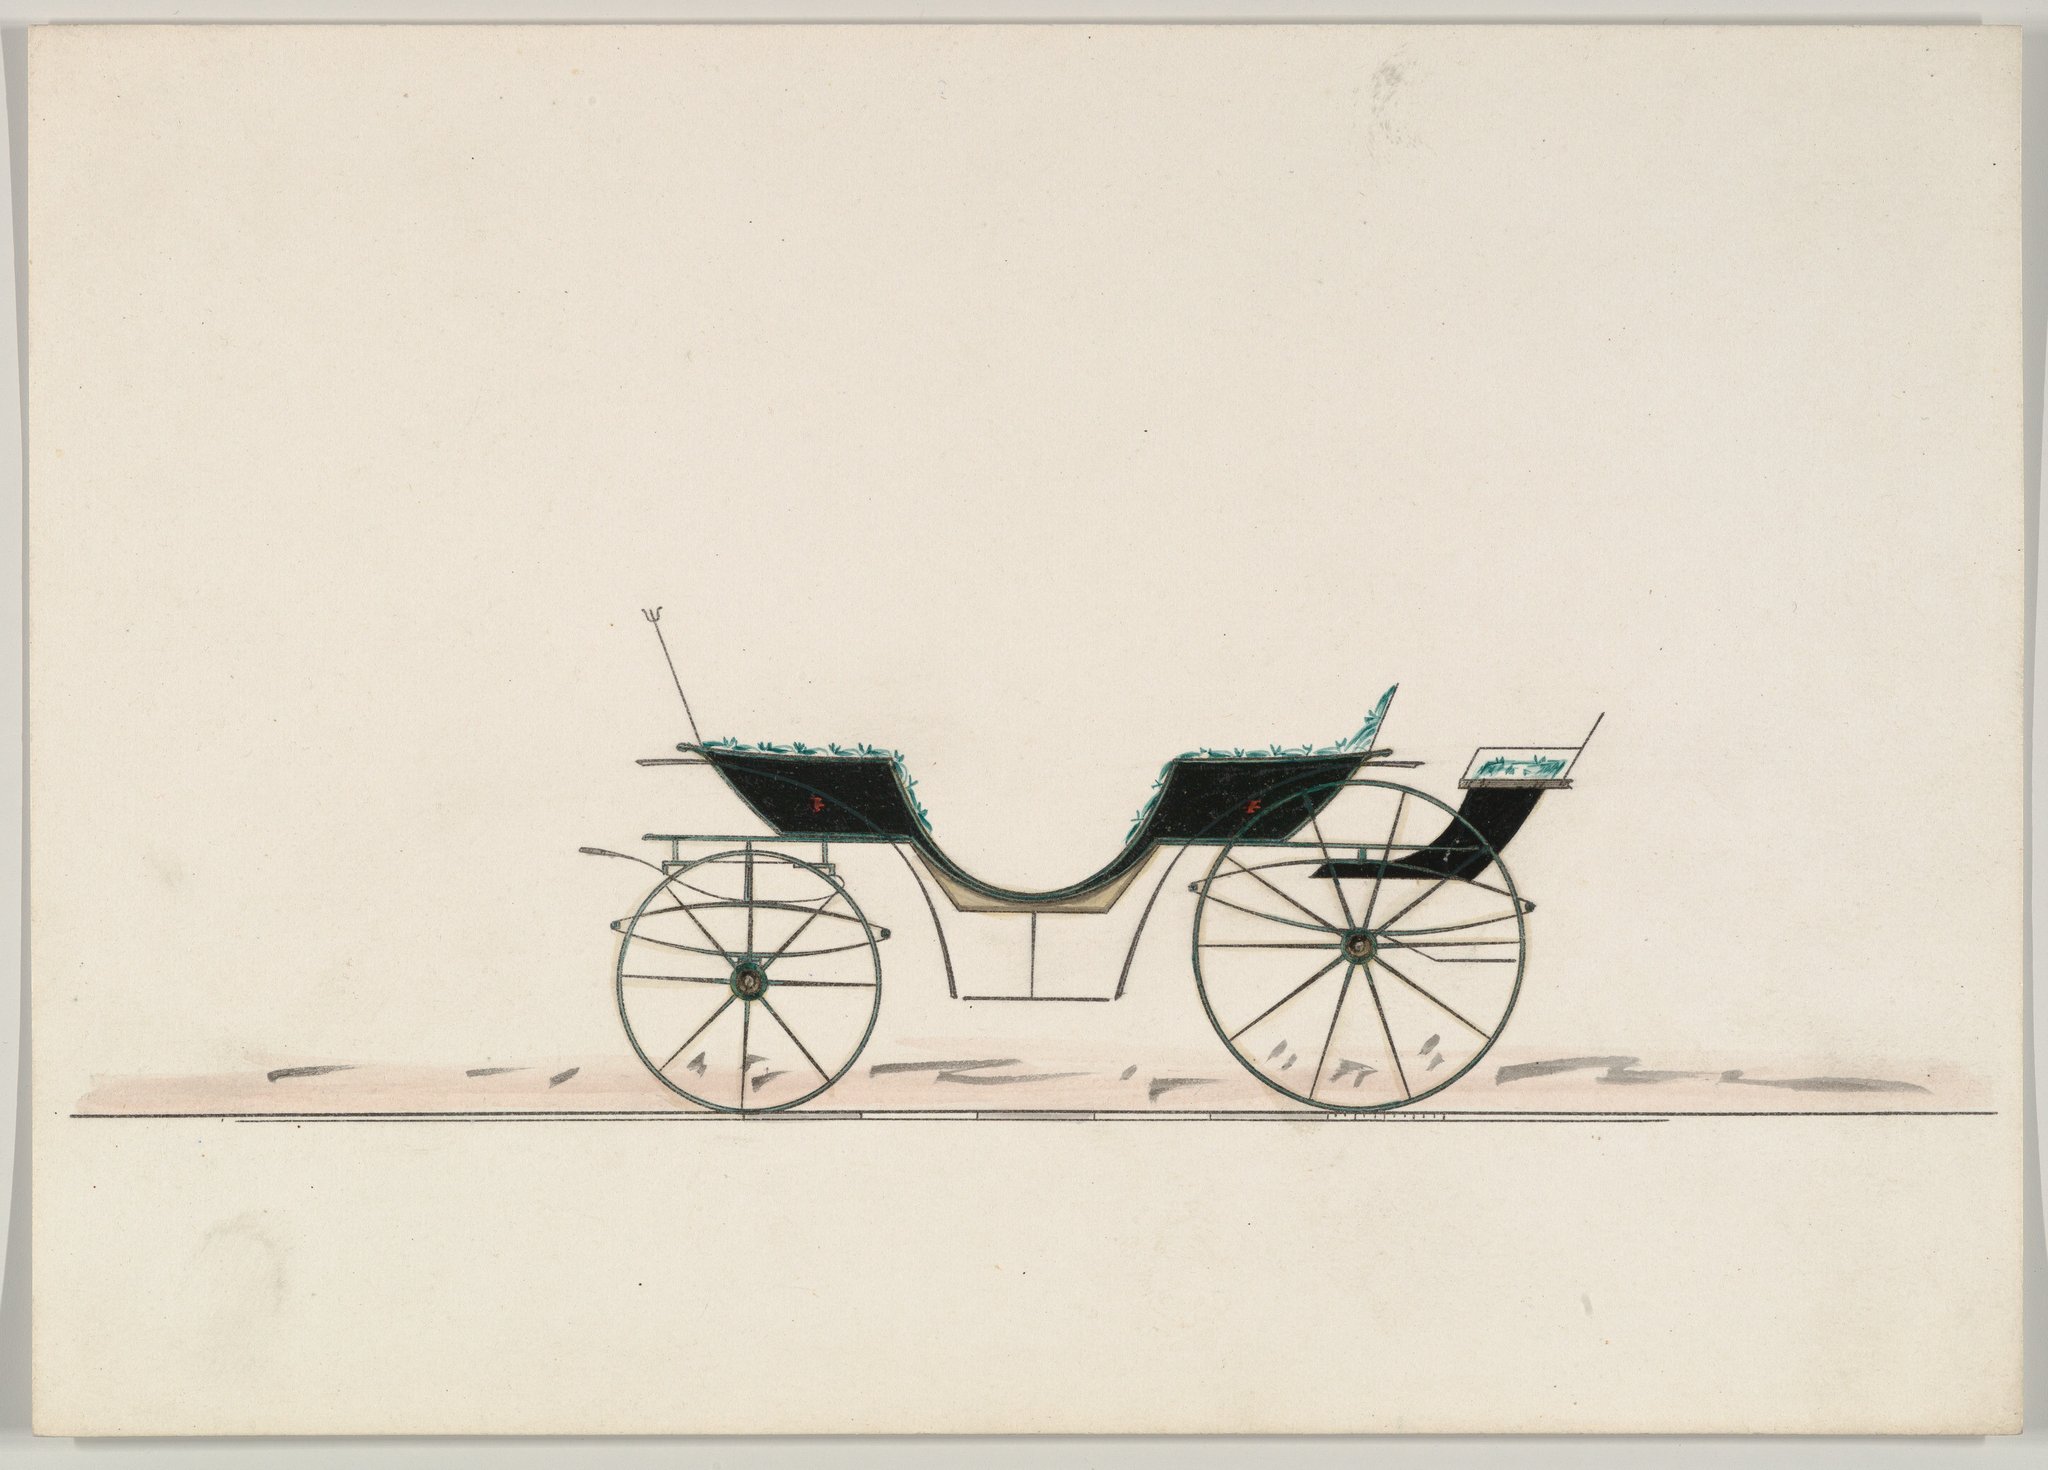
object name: drawing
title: Design for Vis-à-vis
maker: brewster & co.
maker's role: manufacturer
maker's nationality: american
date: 1850-1870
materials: gouache, gum arabic, ink, watercolor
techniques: pen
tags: carriages